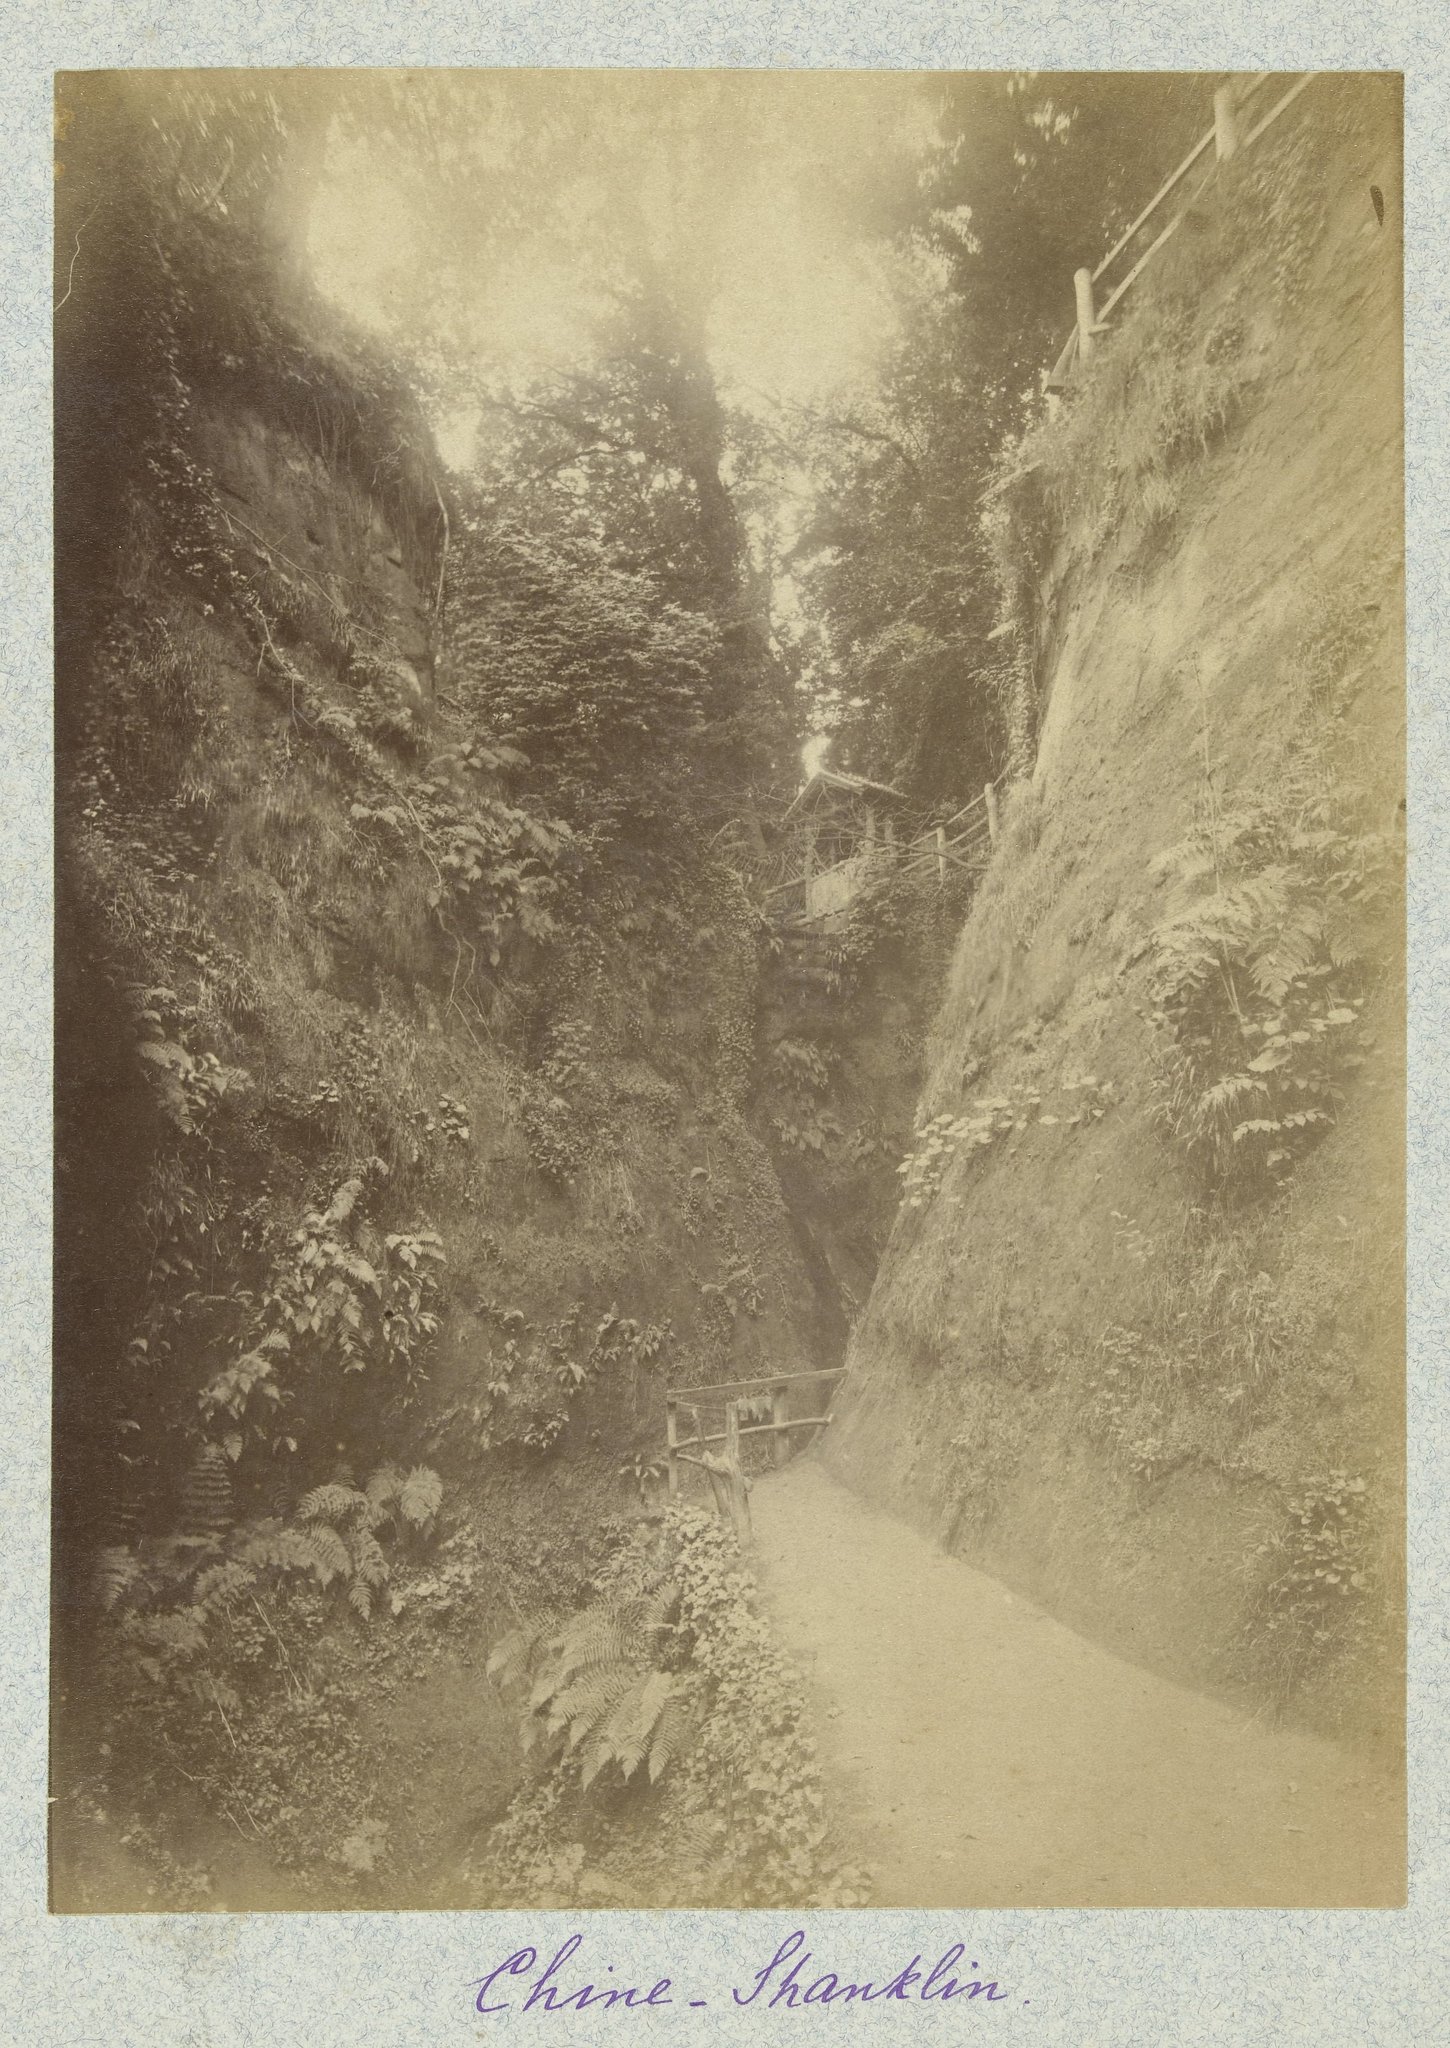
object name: album leaf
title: Gezicht op de Shanklin Chine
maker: henry pauw van wieldrecht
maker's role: fotograaf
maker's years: 1863-1912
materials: cardboard, paper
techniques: albumen print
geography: shanklin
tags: ravine, chasm, abyss, canyon